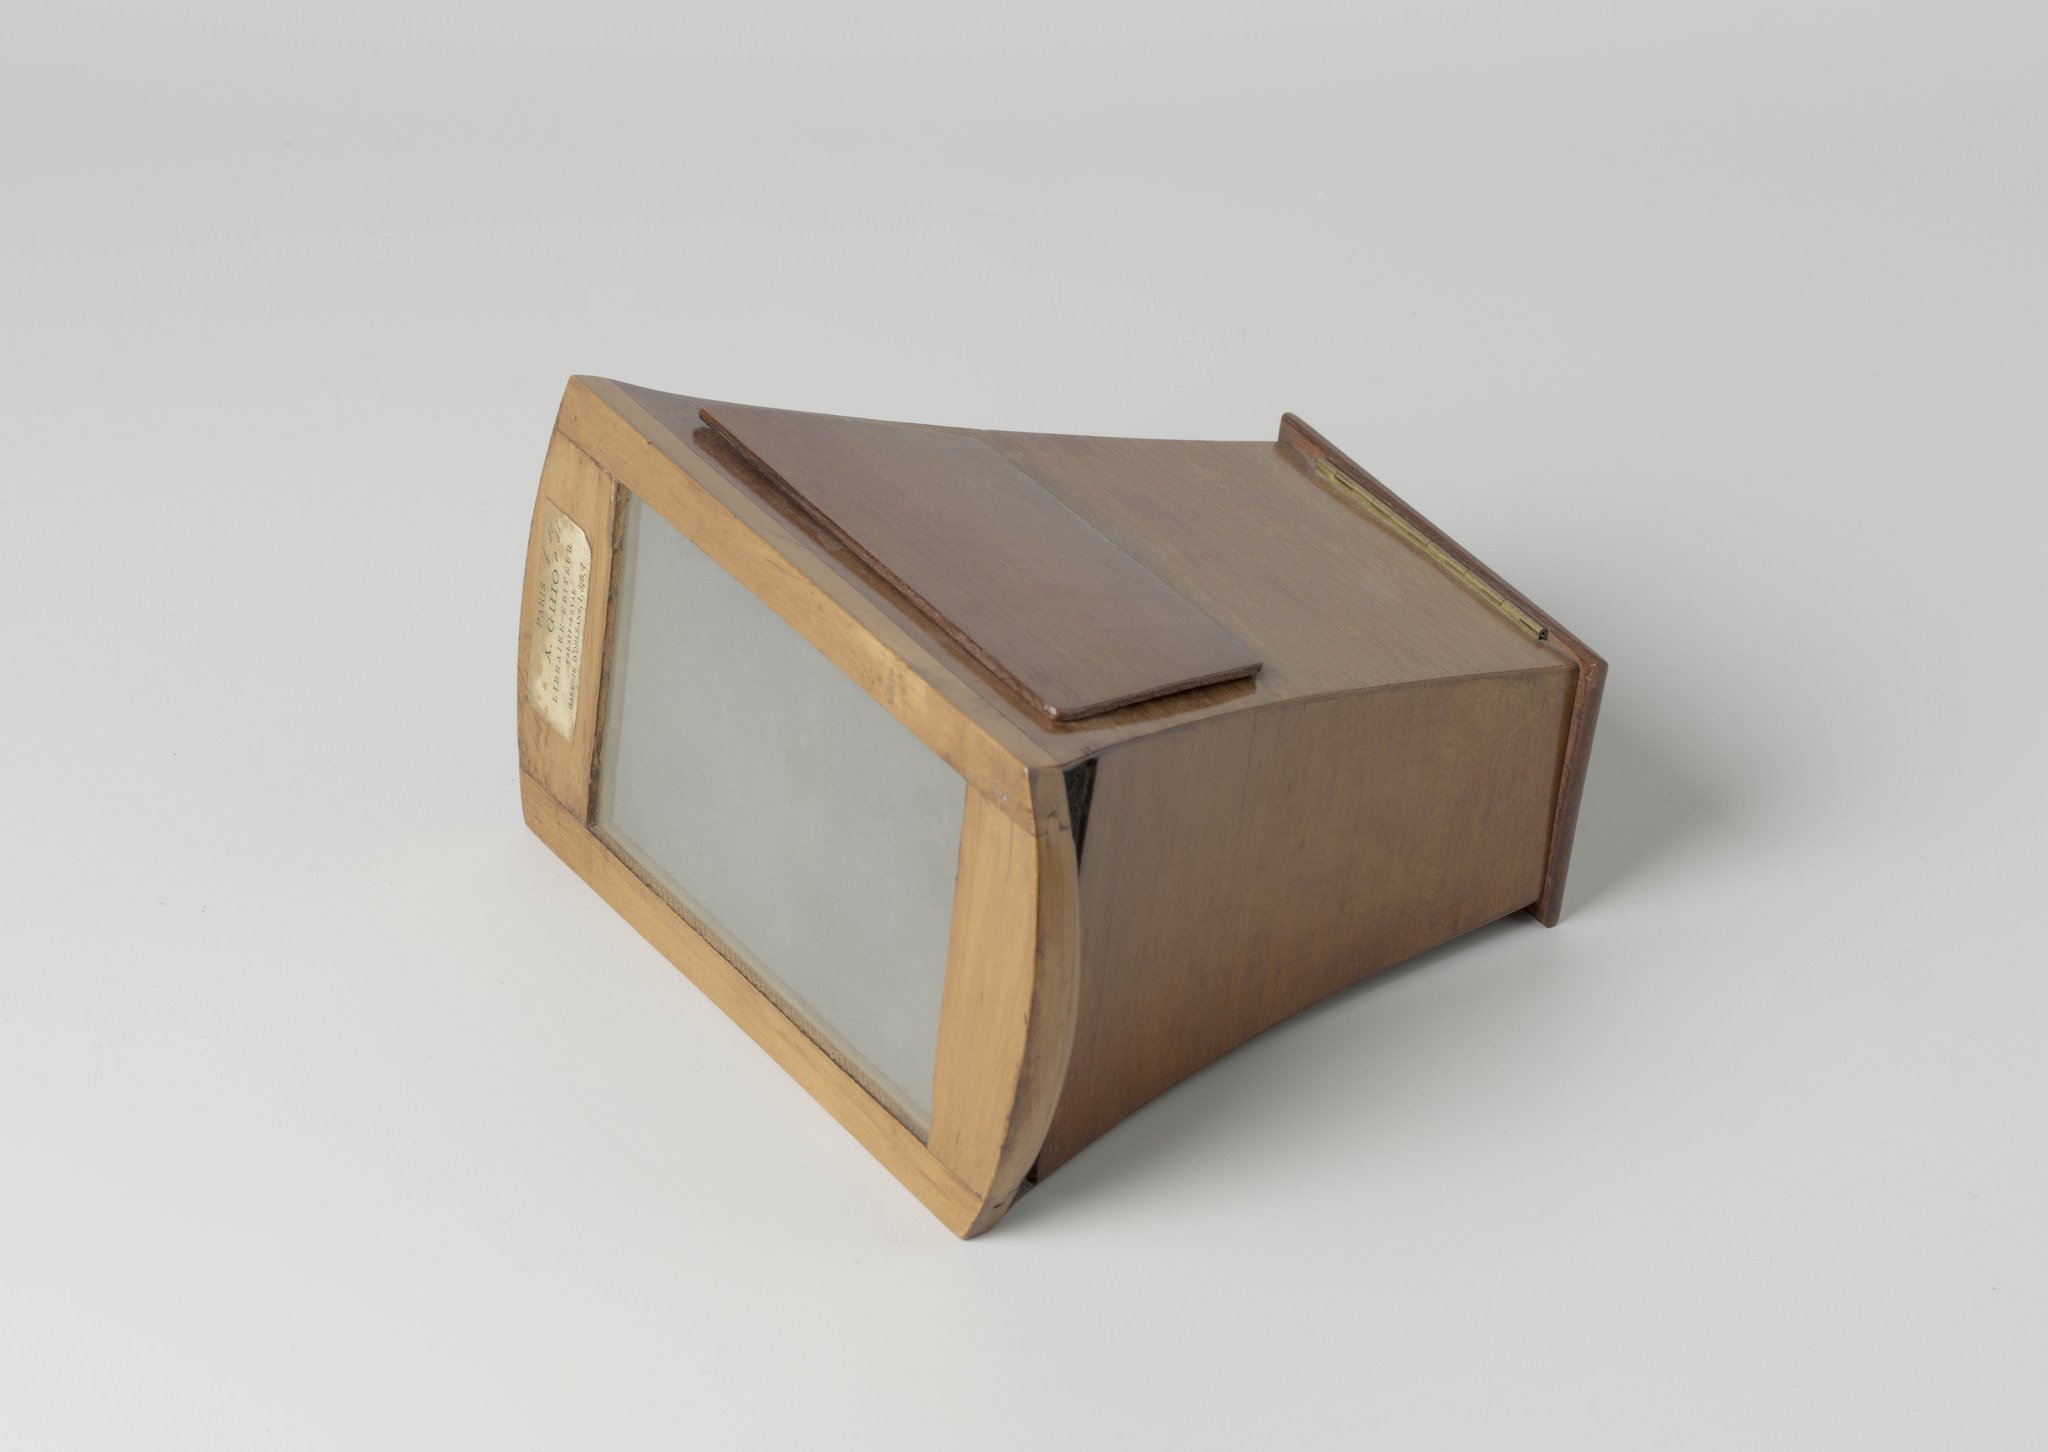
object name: stereoscope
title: Stereokijker (type Brewster)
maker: Anonymous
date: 1855-1900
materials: glass, metal, wood